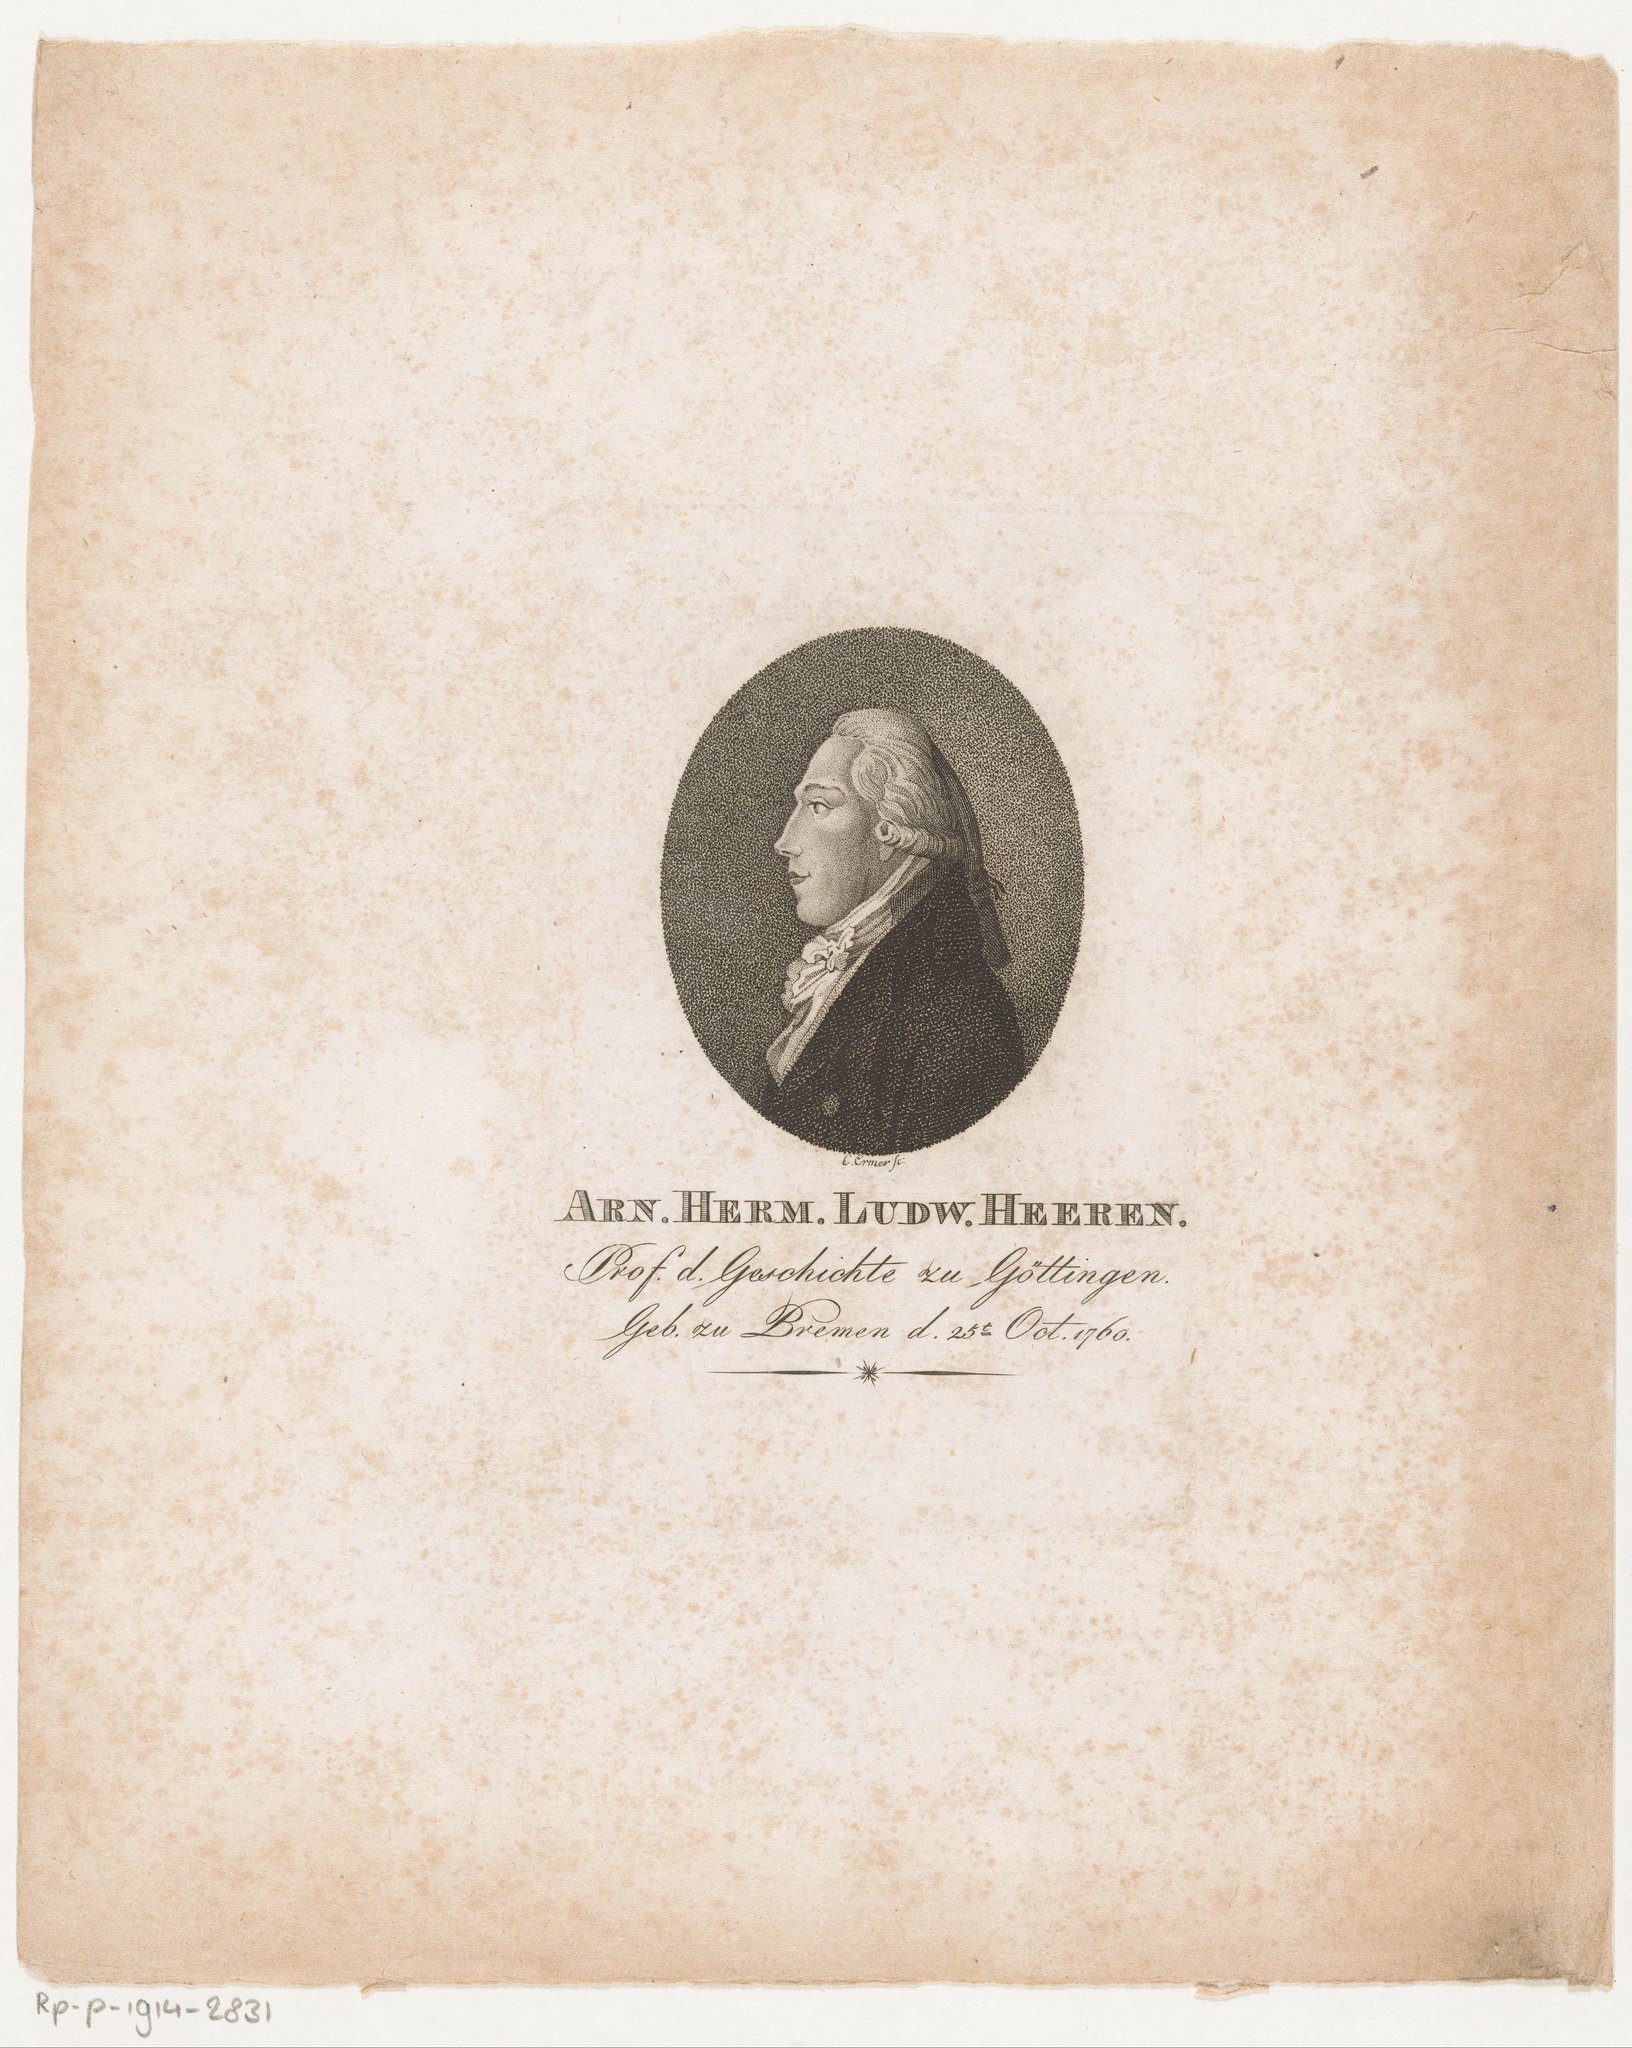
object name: print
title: Portret van Arnold Hermann Ludwig Heeren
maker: christian ermer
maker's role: print maker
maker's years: 1786-1855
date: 1796-1855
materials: paper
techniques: stippling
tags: historical persons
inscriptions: collector's mark: Lugt 2228